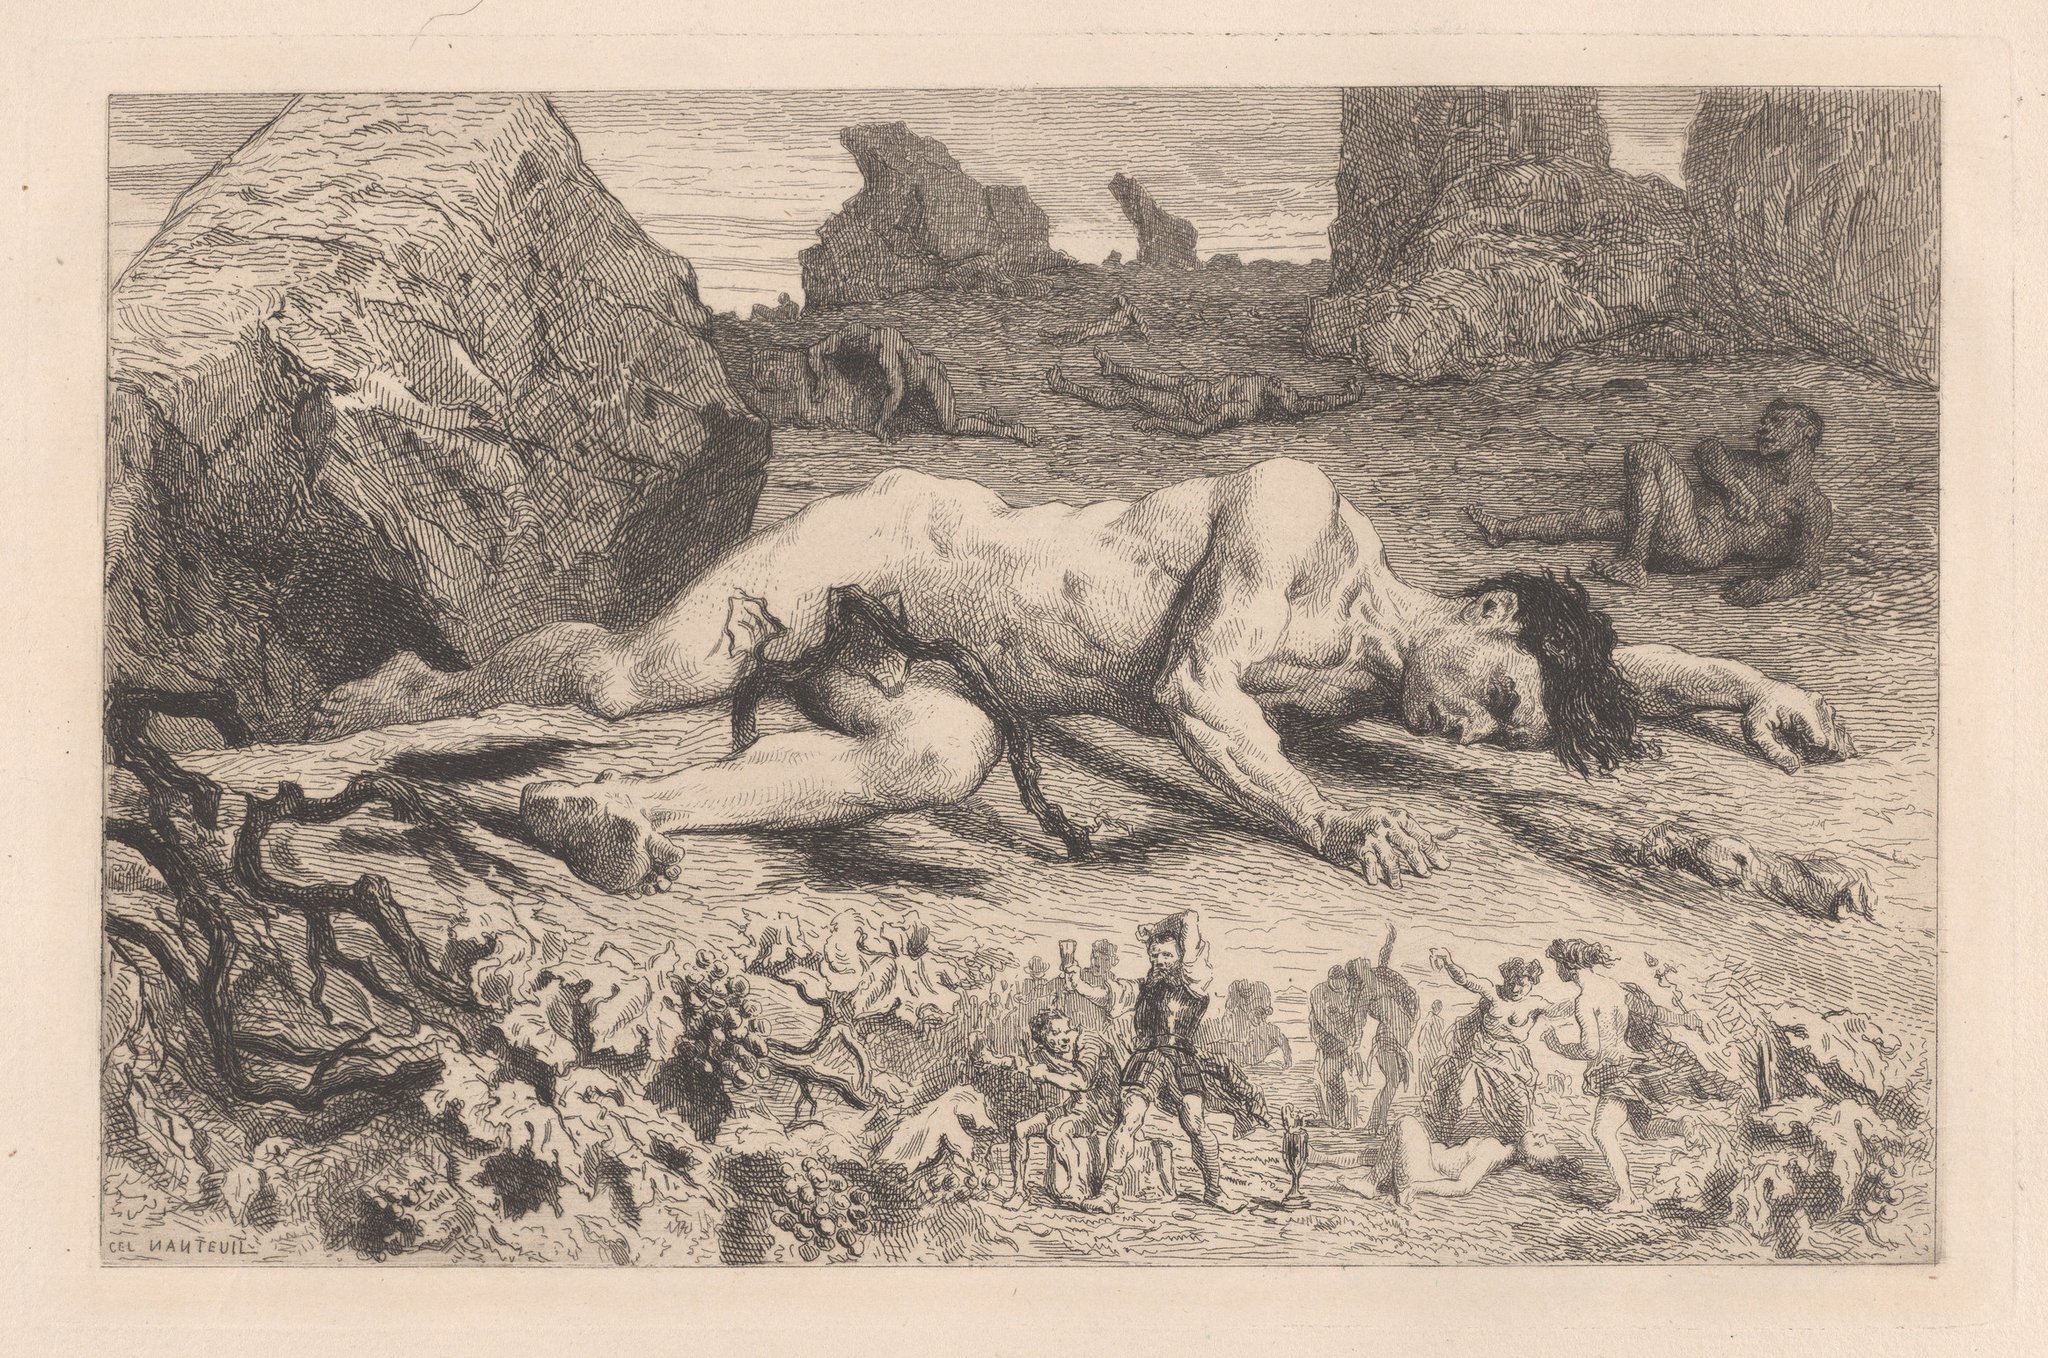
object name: print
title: The Blood of Giants illustration for Louis Bouilhet's sonnet in "Sonnets and Etchings"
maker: j. bouilhet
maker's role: author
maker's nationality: french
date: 1869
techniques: etching